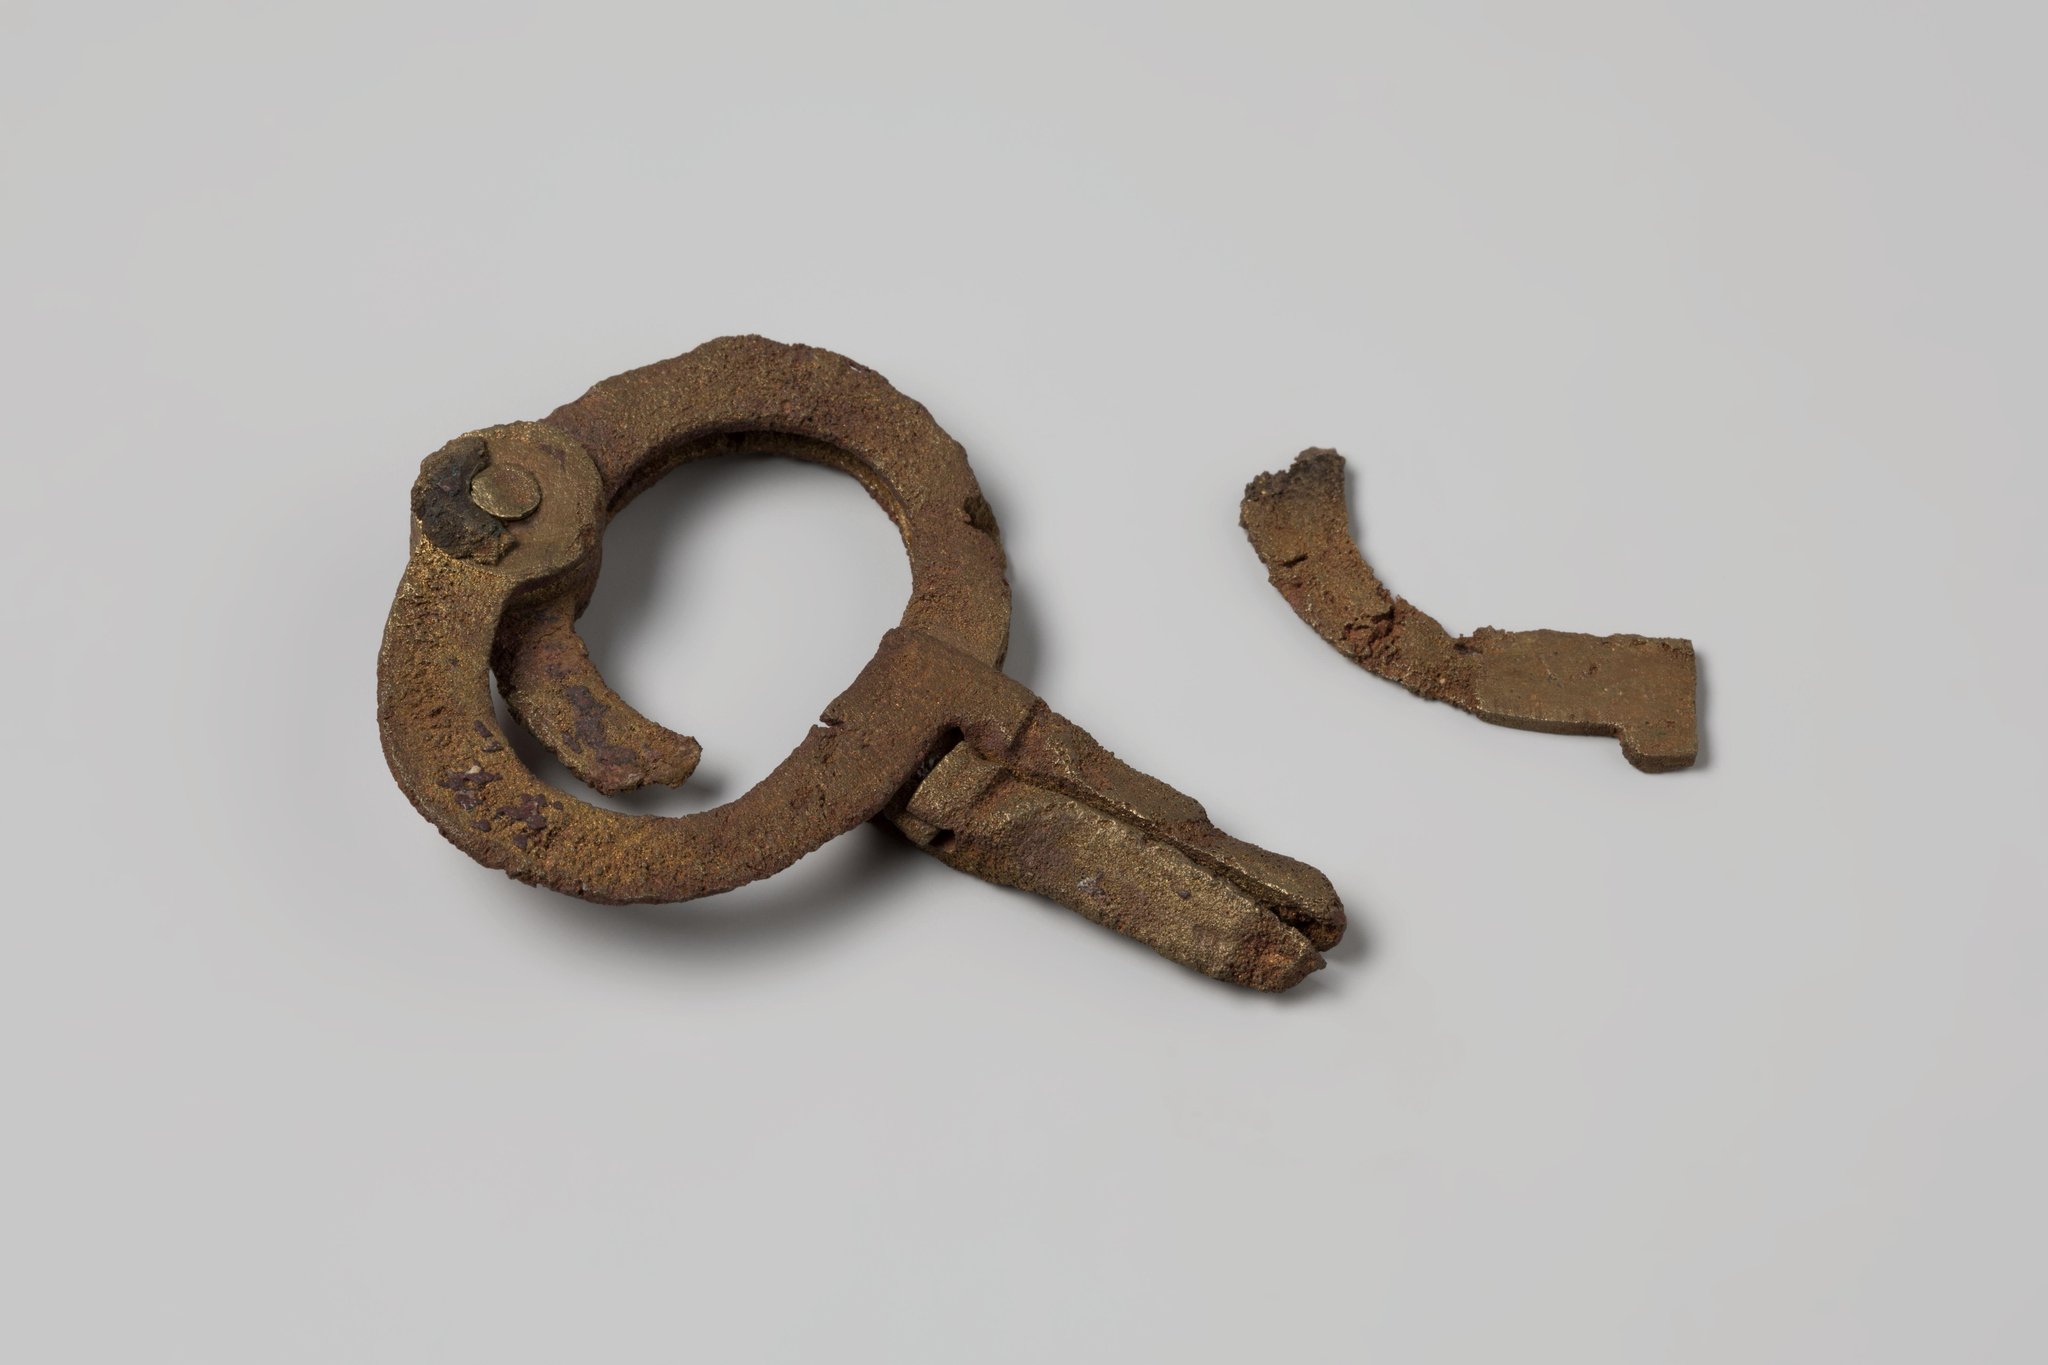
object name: divider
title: Steekpasser met los fragment uit het wrak van de Oost-Indiëvaarder Hollandia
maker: Anonymous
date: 1700-1743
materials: copper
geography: netherlands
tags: verenigde oostindische compagnie, hollandia (schip), annet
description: Divider; eroded: consisting of 2 legs, id. NG 1980-27H1171, each with a single semicircular ring, flat in section, with a circular pivot eye at end, interlocking with 2 id. rings, each slotted into one of the legs, hinged.